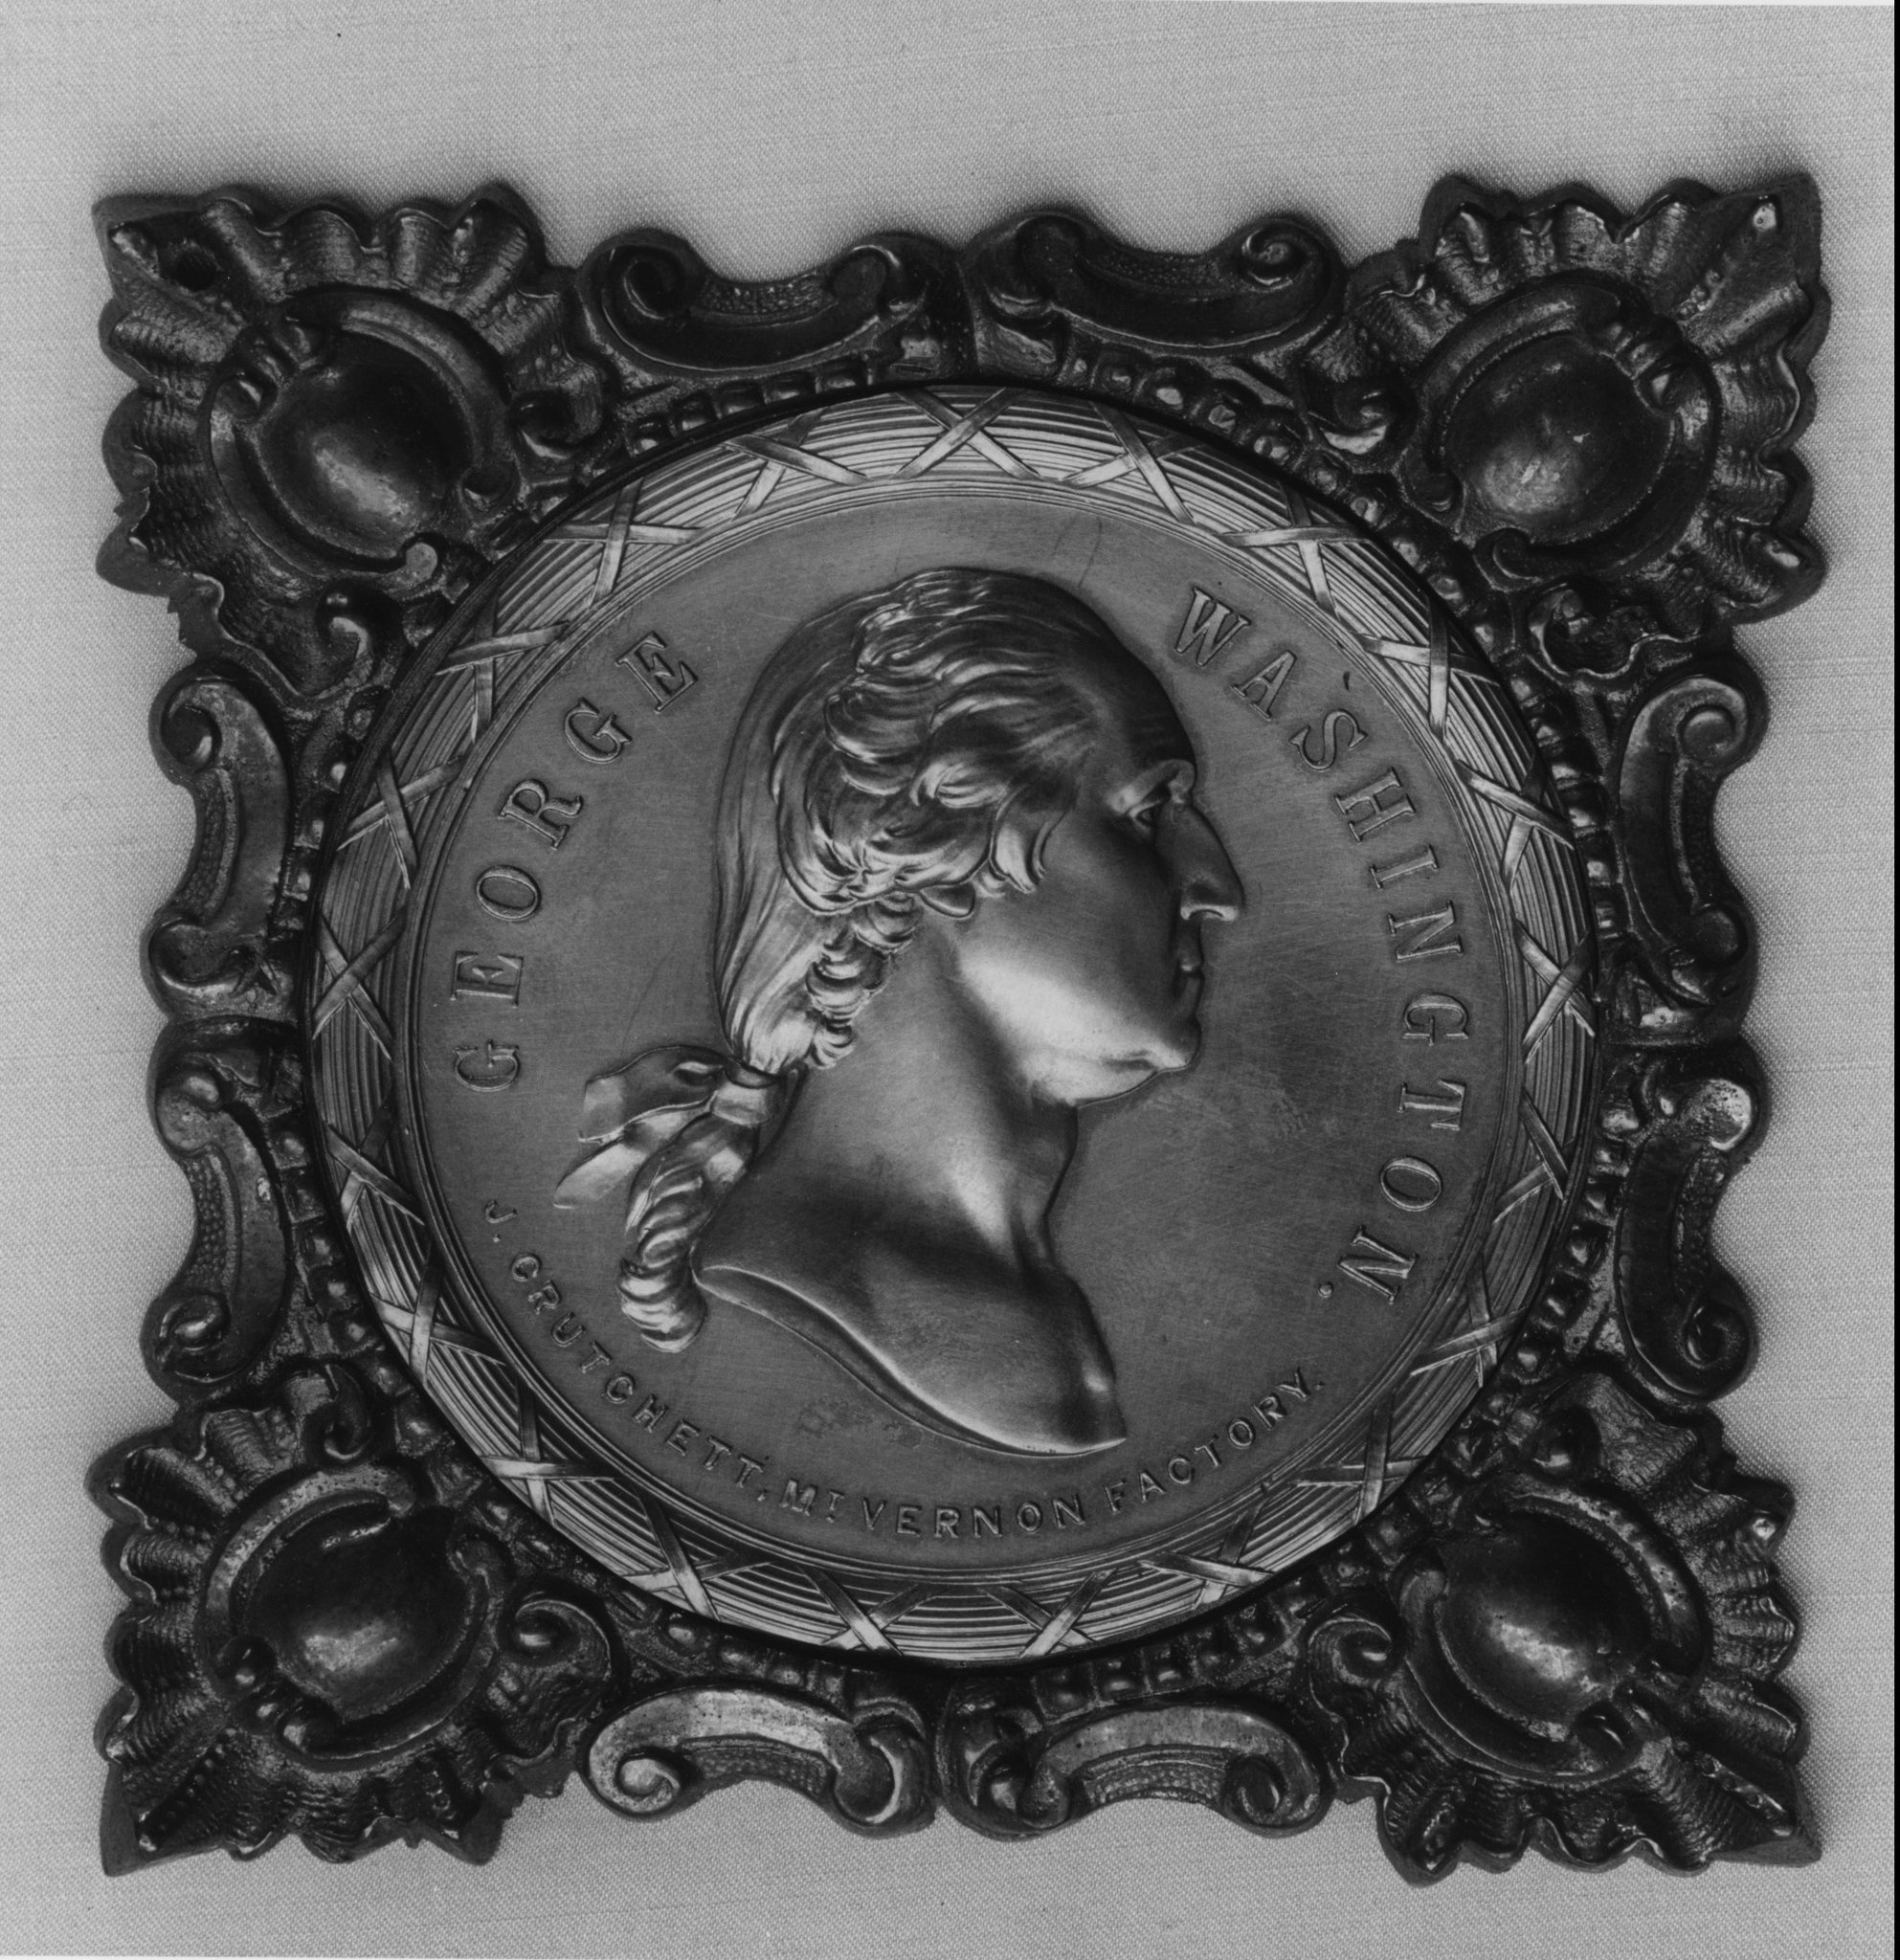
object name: medal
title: Medal of George Washington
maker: j. crutchett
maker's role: maker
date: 1800-1883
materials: copper gilt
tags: george washington,men,profiles